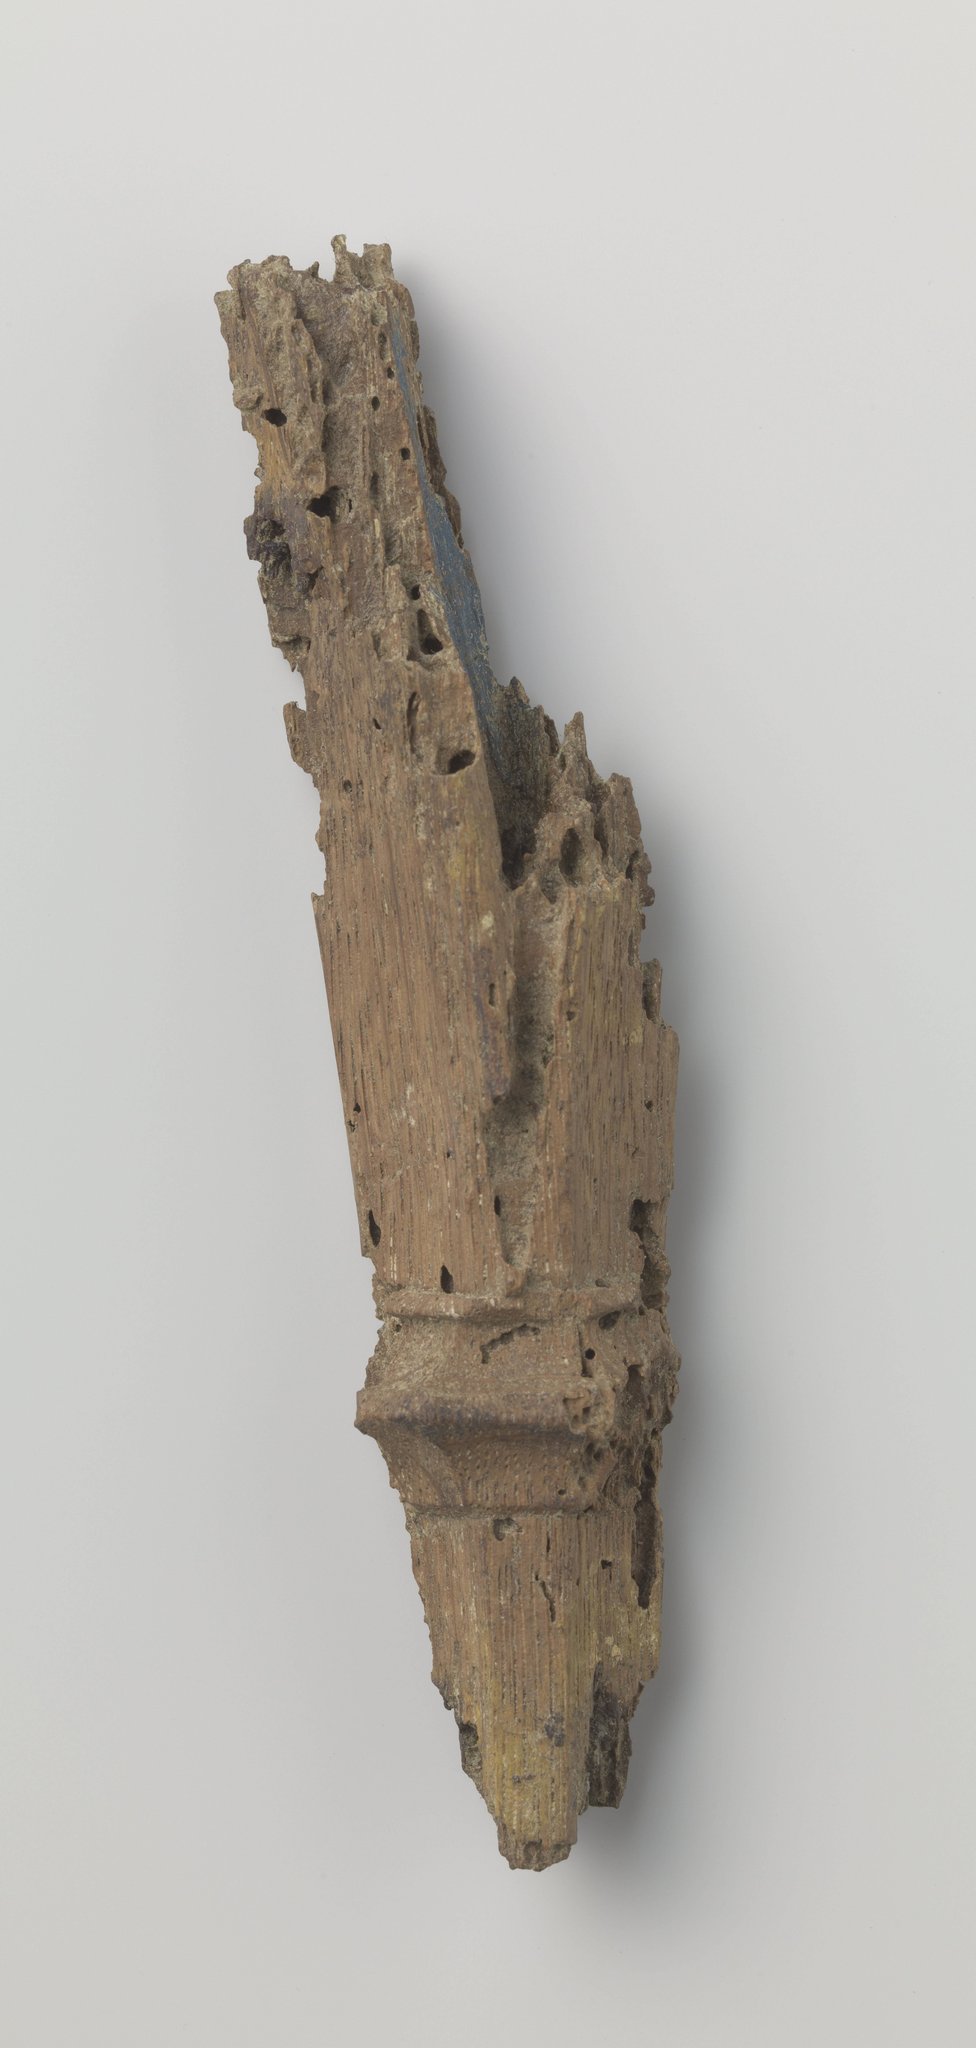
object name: fragment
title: Fragment; (mogelijk) behorend tot het retabel van Soest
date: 1475-1499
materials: wood